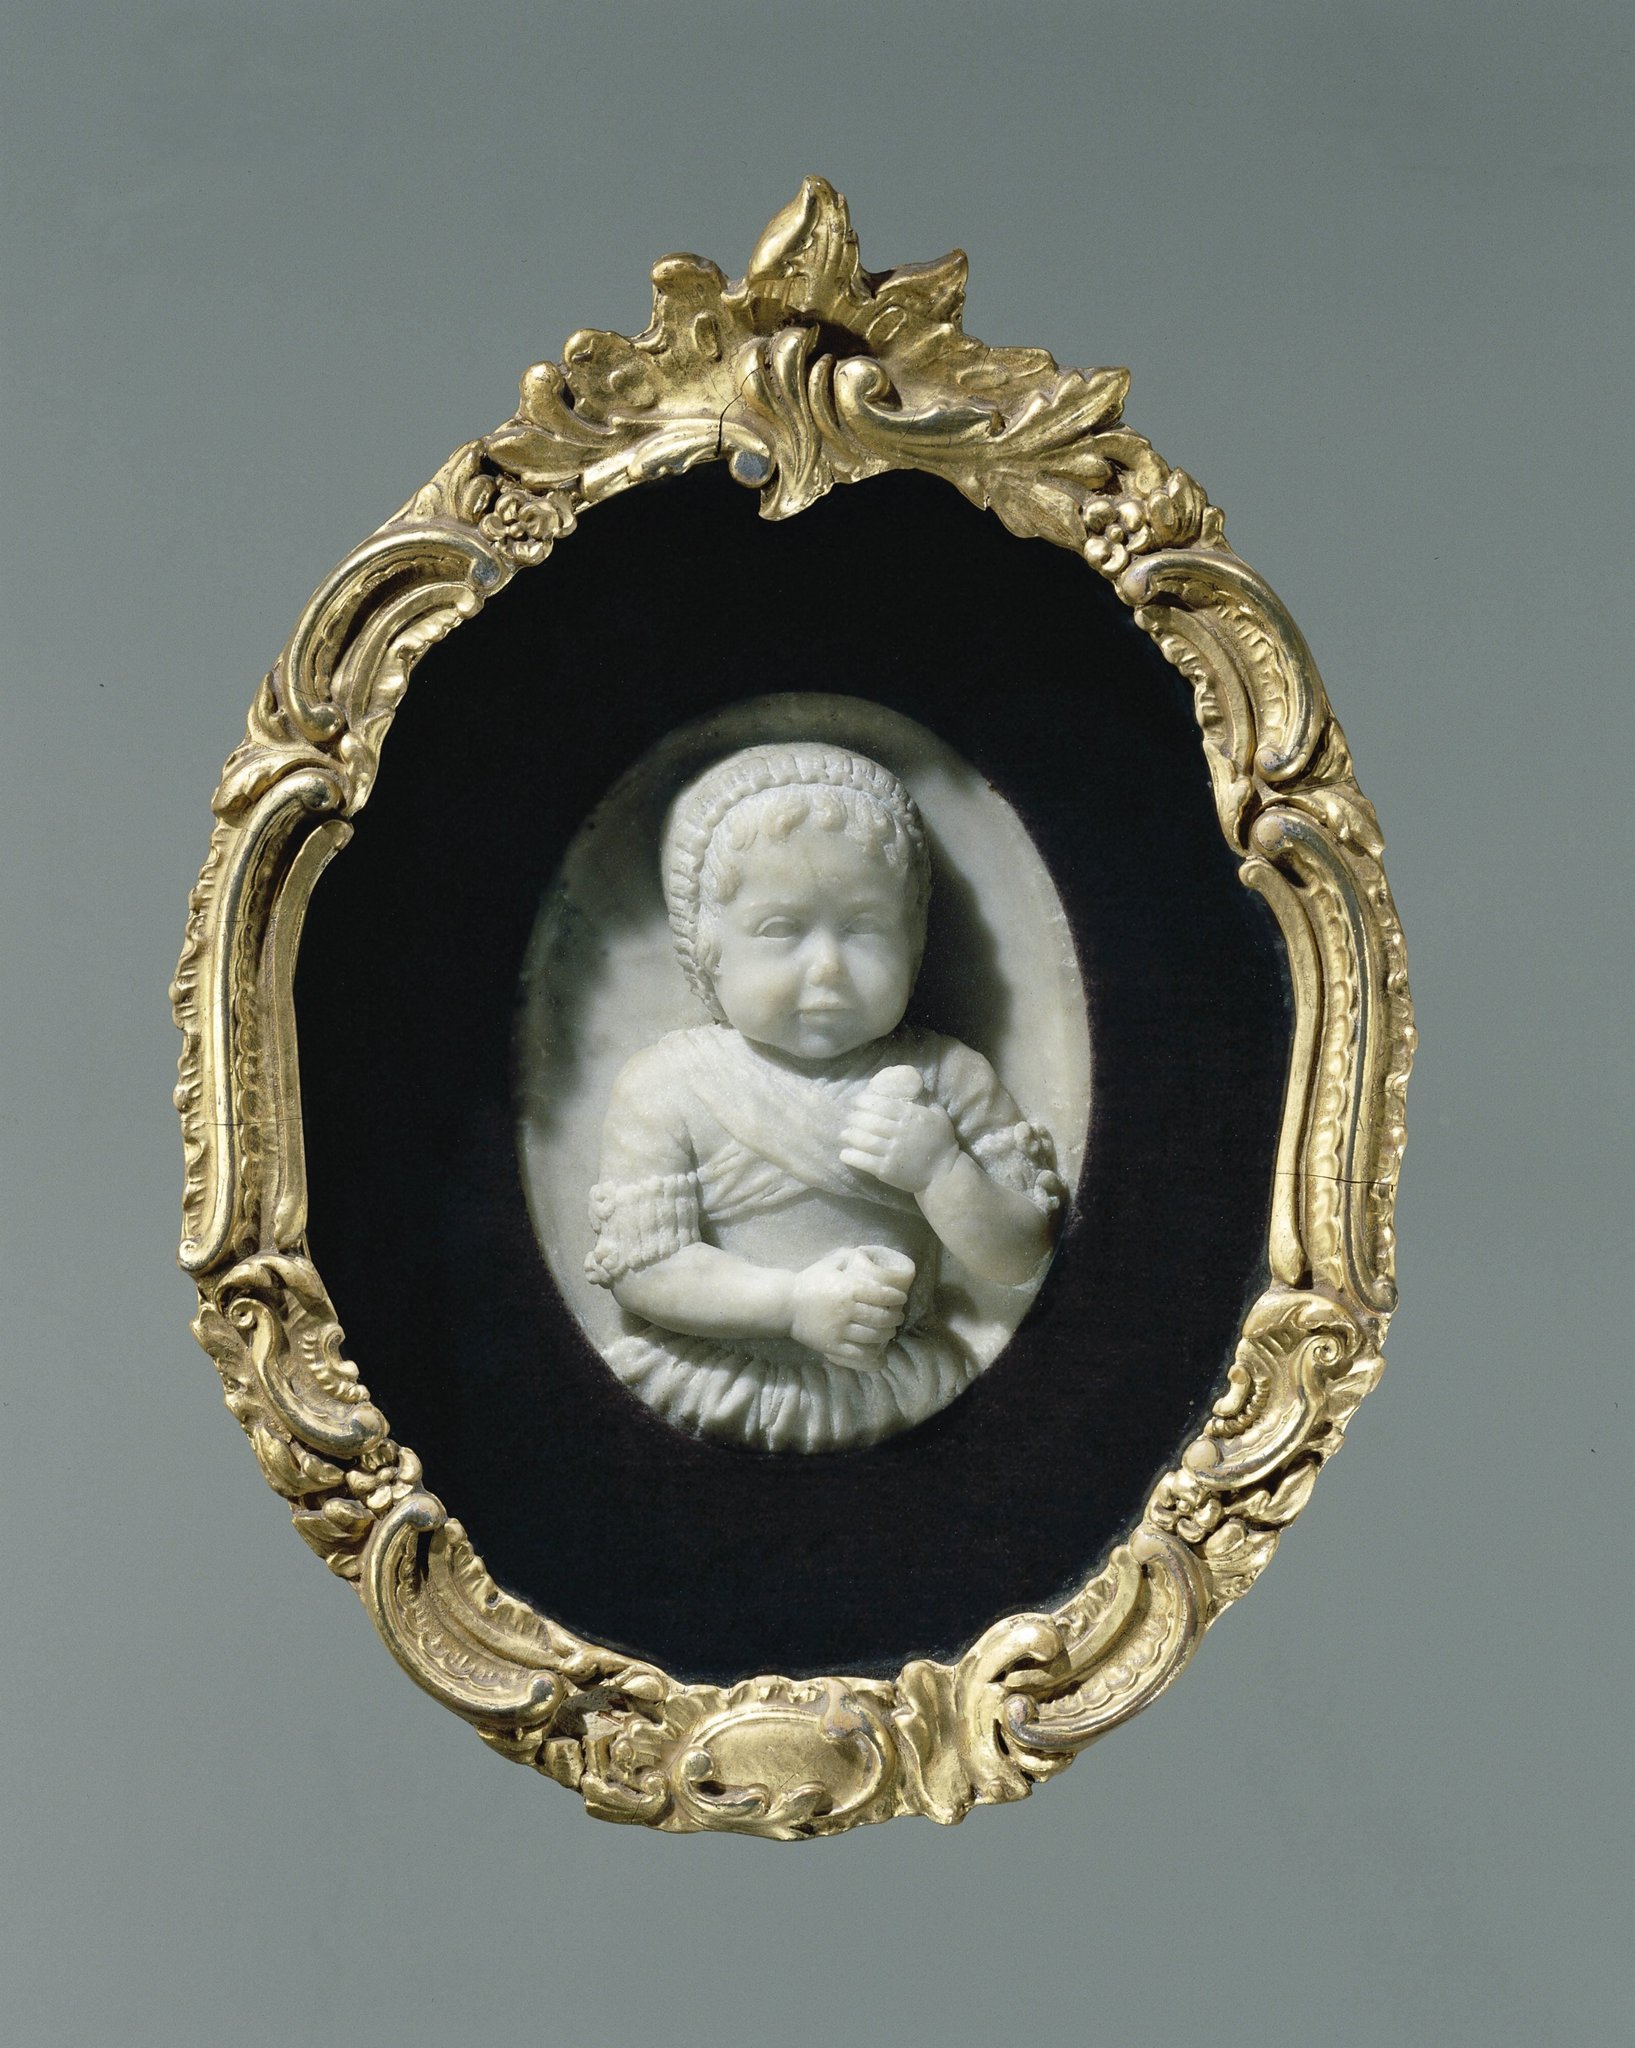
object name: sculpture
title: Portretmedaillon in marmer van Johannes Christoffer Mittscherlich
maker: christoffel mittscherlich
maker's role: silversmith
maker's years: 1740-1793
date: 1785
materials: marble, wood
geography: amsterdam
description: Portretmedaillon in marmer van Johannes Christoffer Mittscherlich op ongeveer vierjaarige leeftijd. In 19de eeuwse verguld houten lijst.